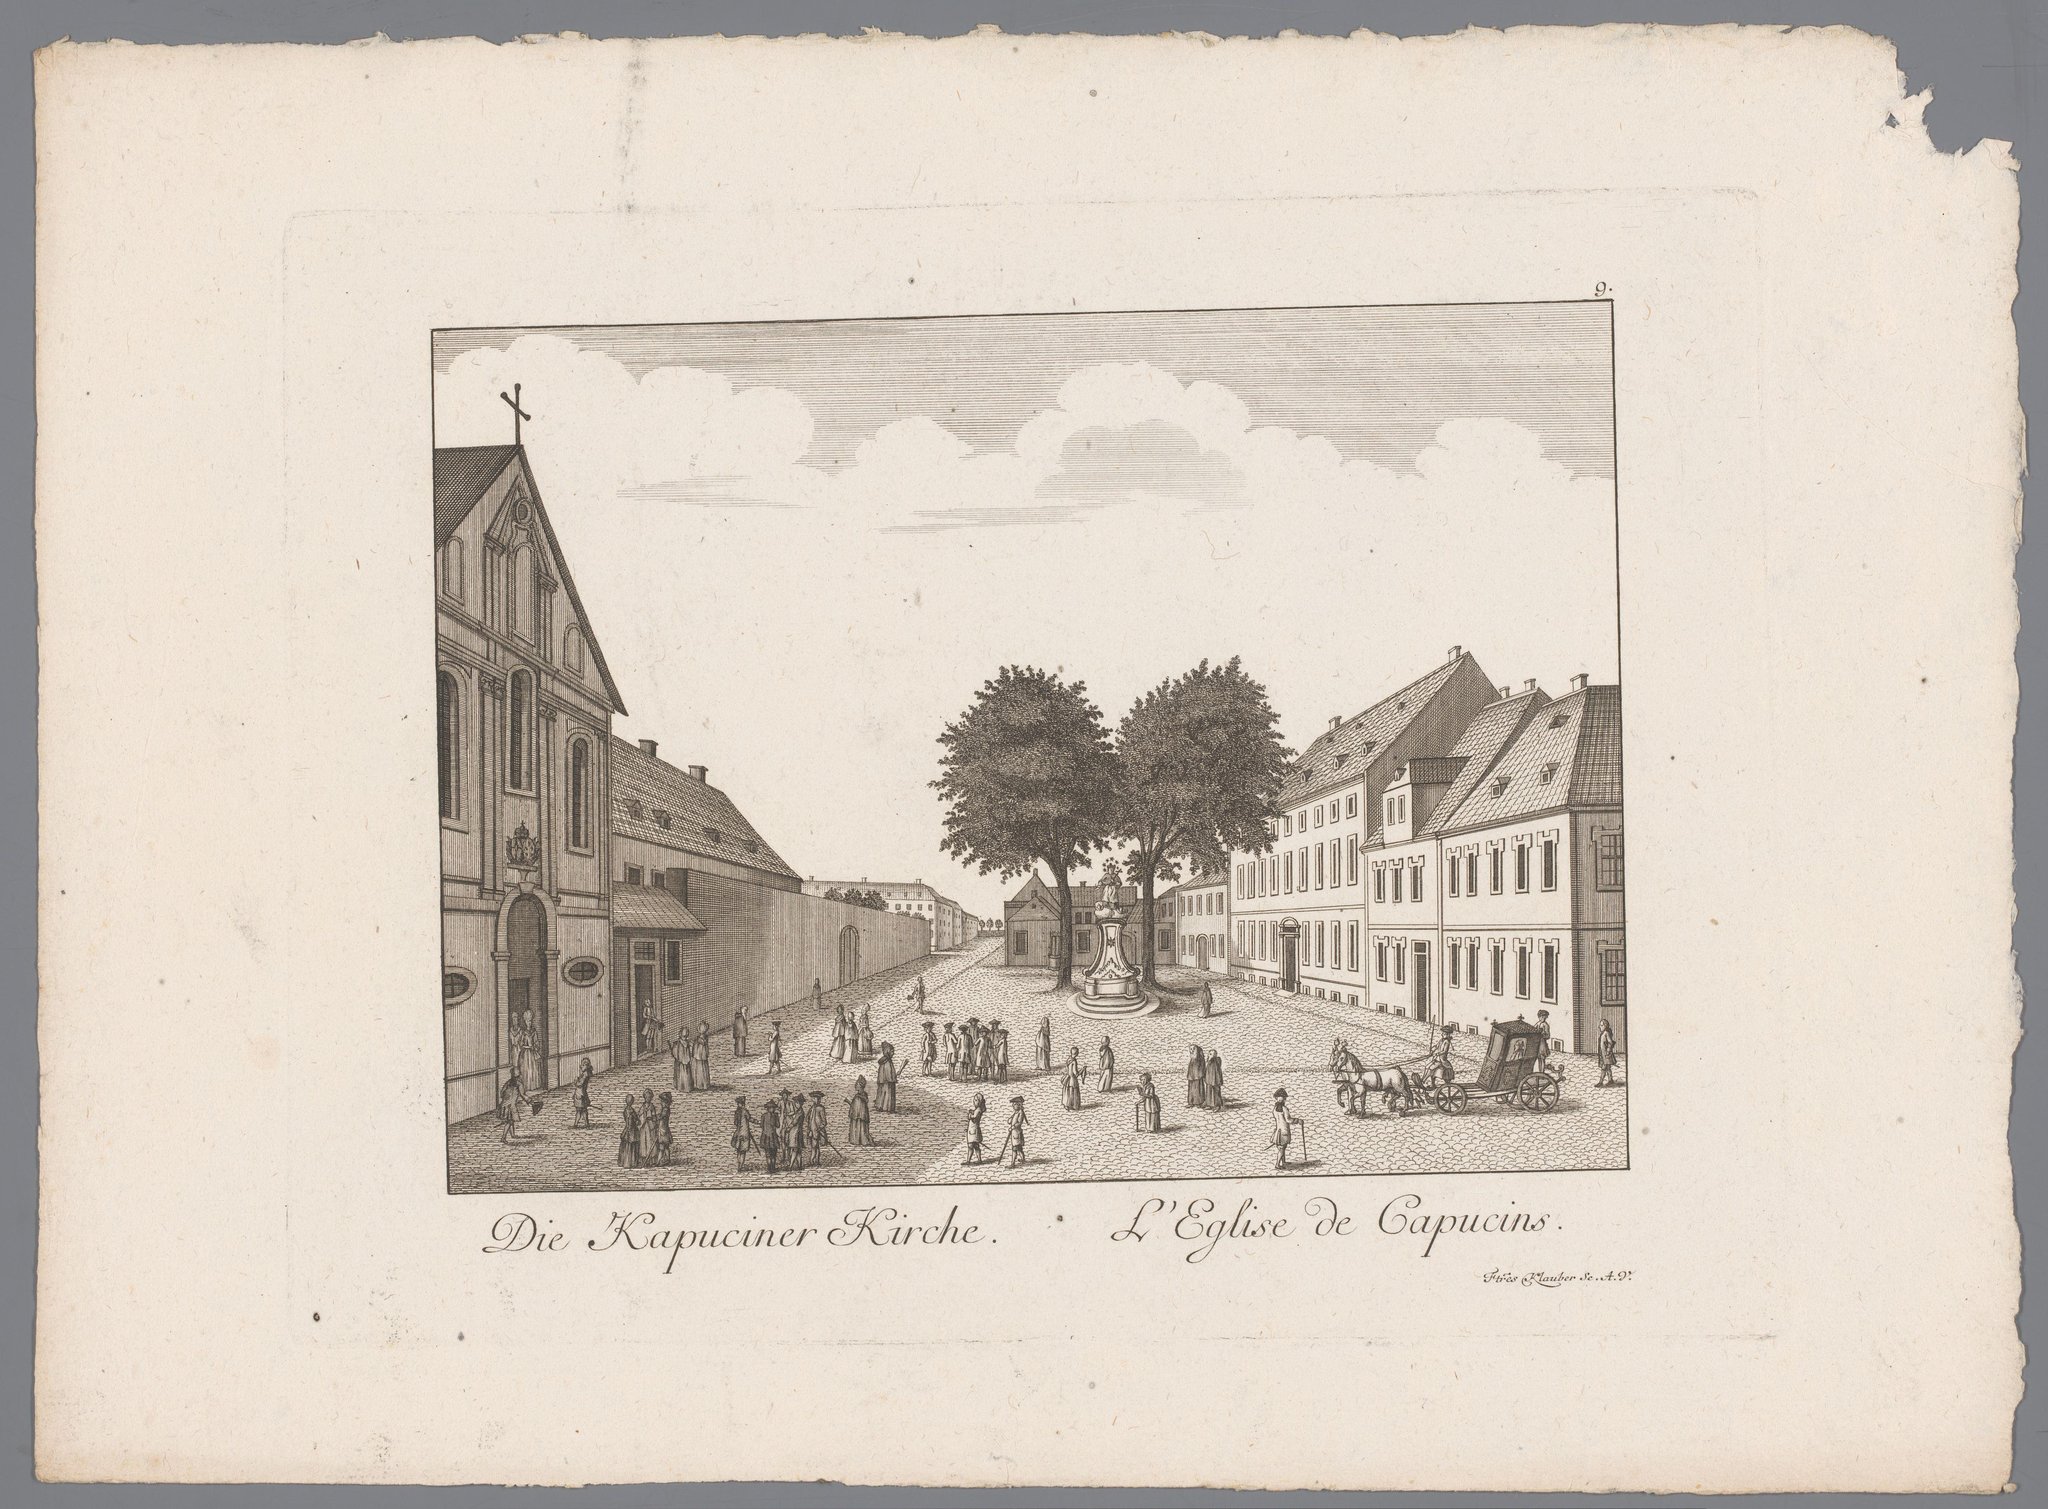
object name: print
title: Vues de Mannheim représentées sur vingt six planches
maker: christian friedrich schwan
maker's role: bookseller, publisher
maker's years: 1733-1815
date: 1782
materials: paper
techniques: engraving, etching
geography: mannheim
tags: church (exterior), cloisters ~ monastery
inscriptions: collector's mark: Lugt 2228